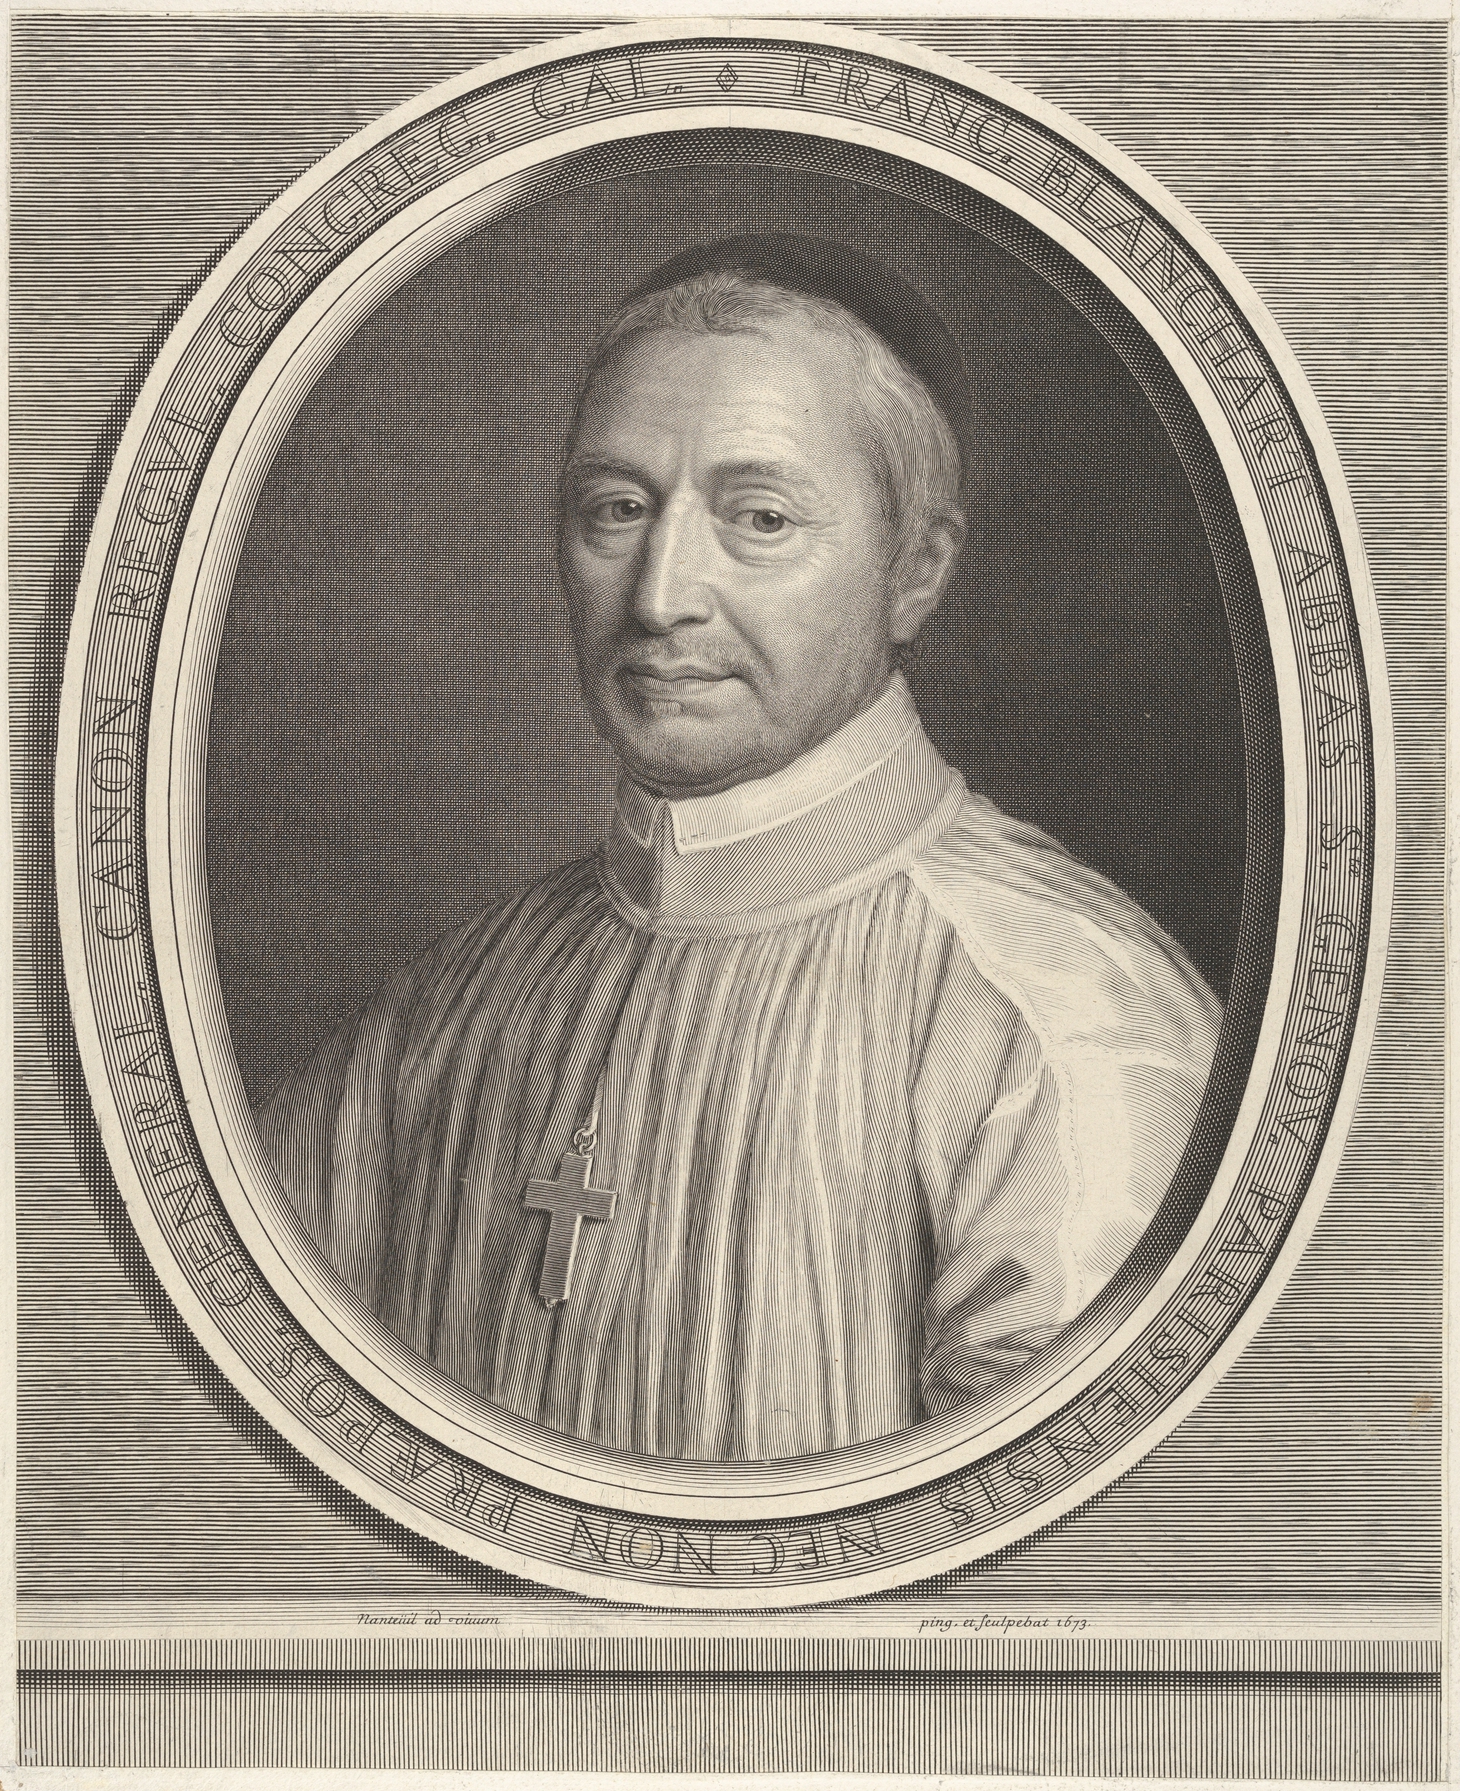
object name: print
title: François Blanchart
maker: robert nanteuil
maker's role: artist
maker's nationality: french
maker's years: 1623-1678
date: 1673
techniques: engraving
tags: men,portraits,cross